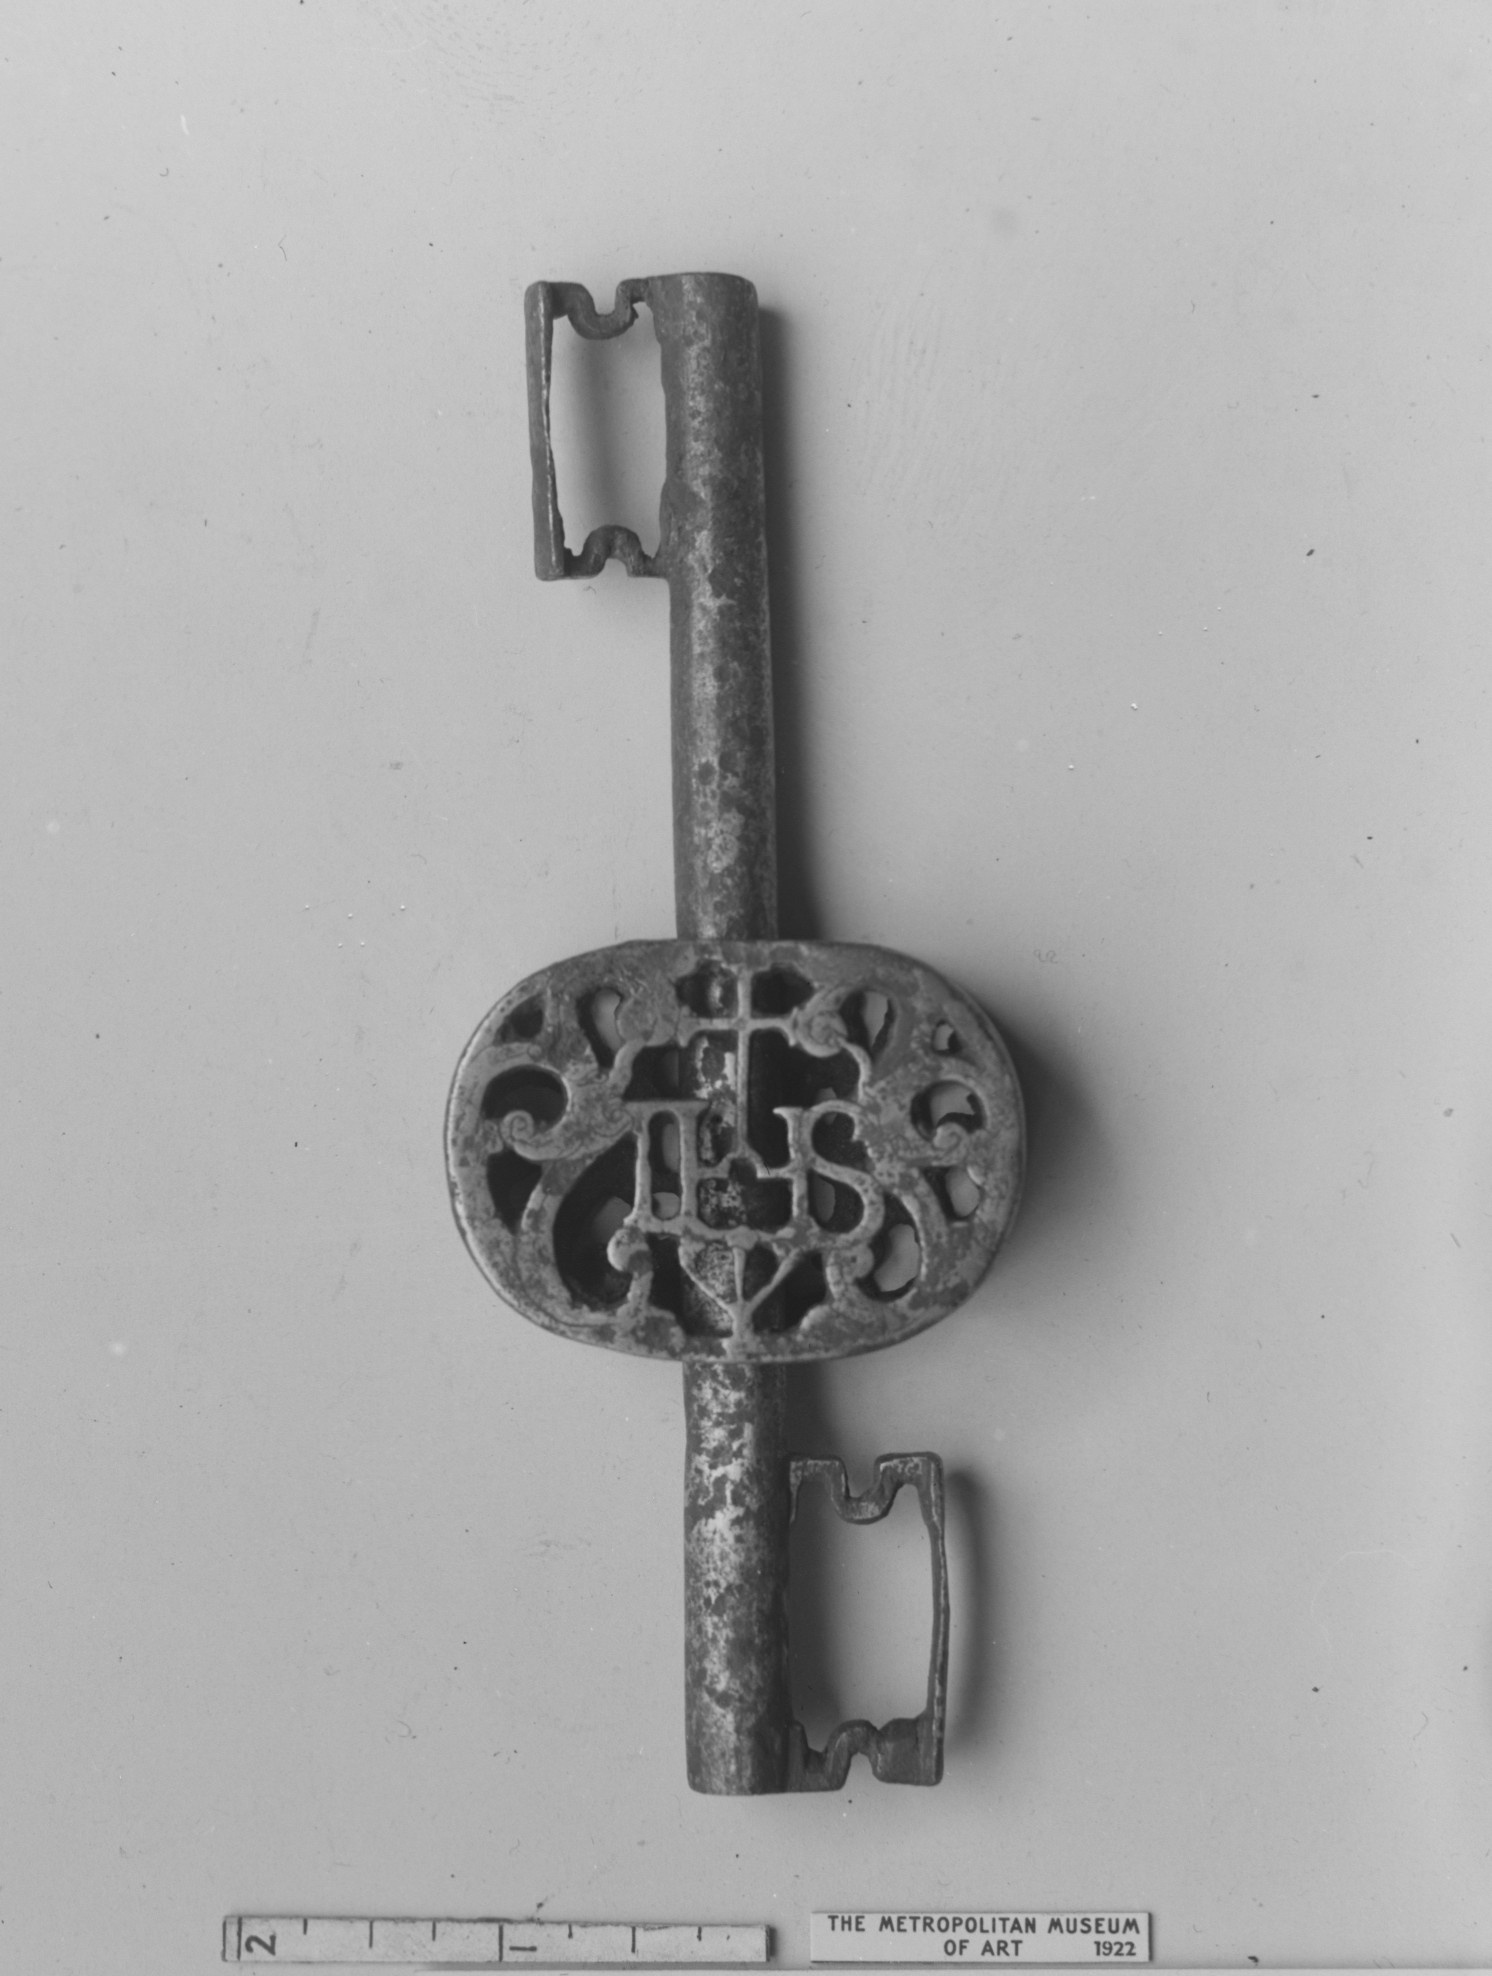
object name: key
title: Duplex key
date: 1667-1700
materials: steel